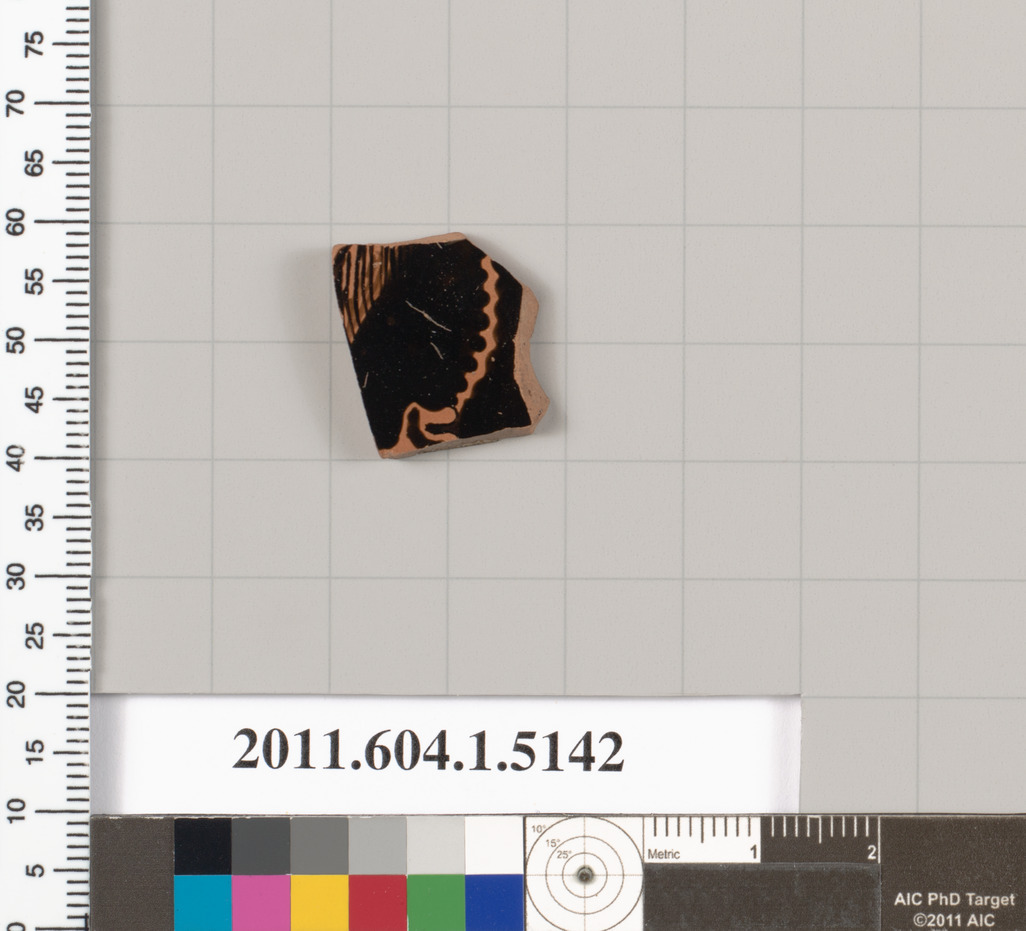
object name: kylix fragment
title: Terracotta fragment of a kylix (drinking cup)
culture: greek, attic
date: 510-490 BCE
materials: terracotta